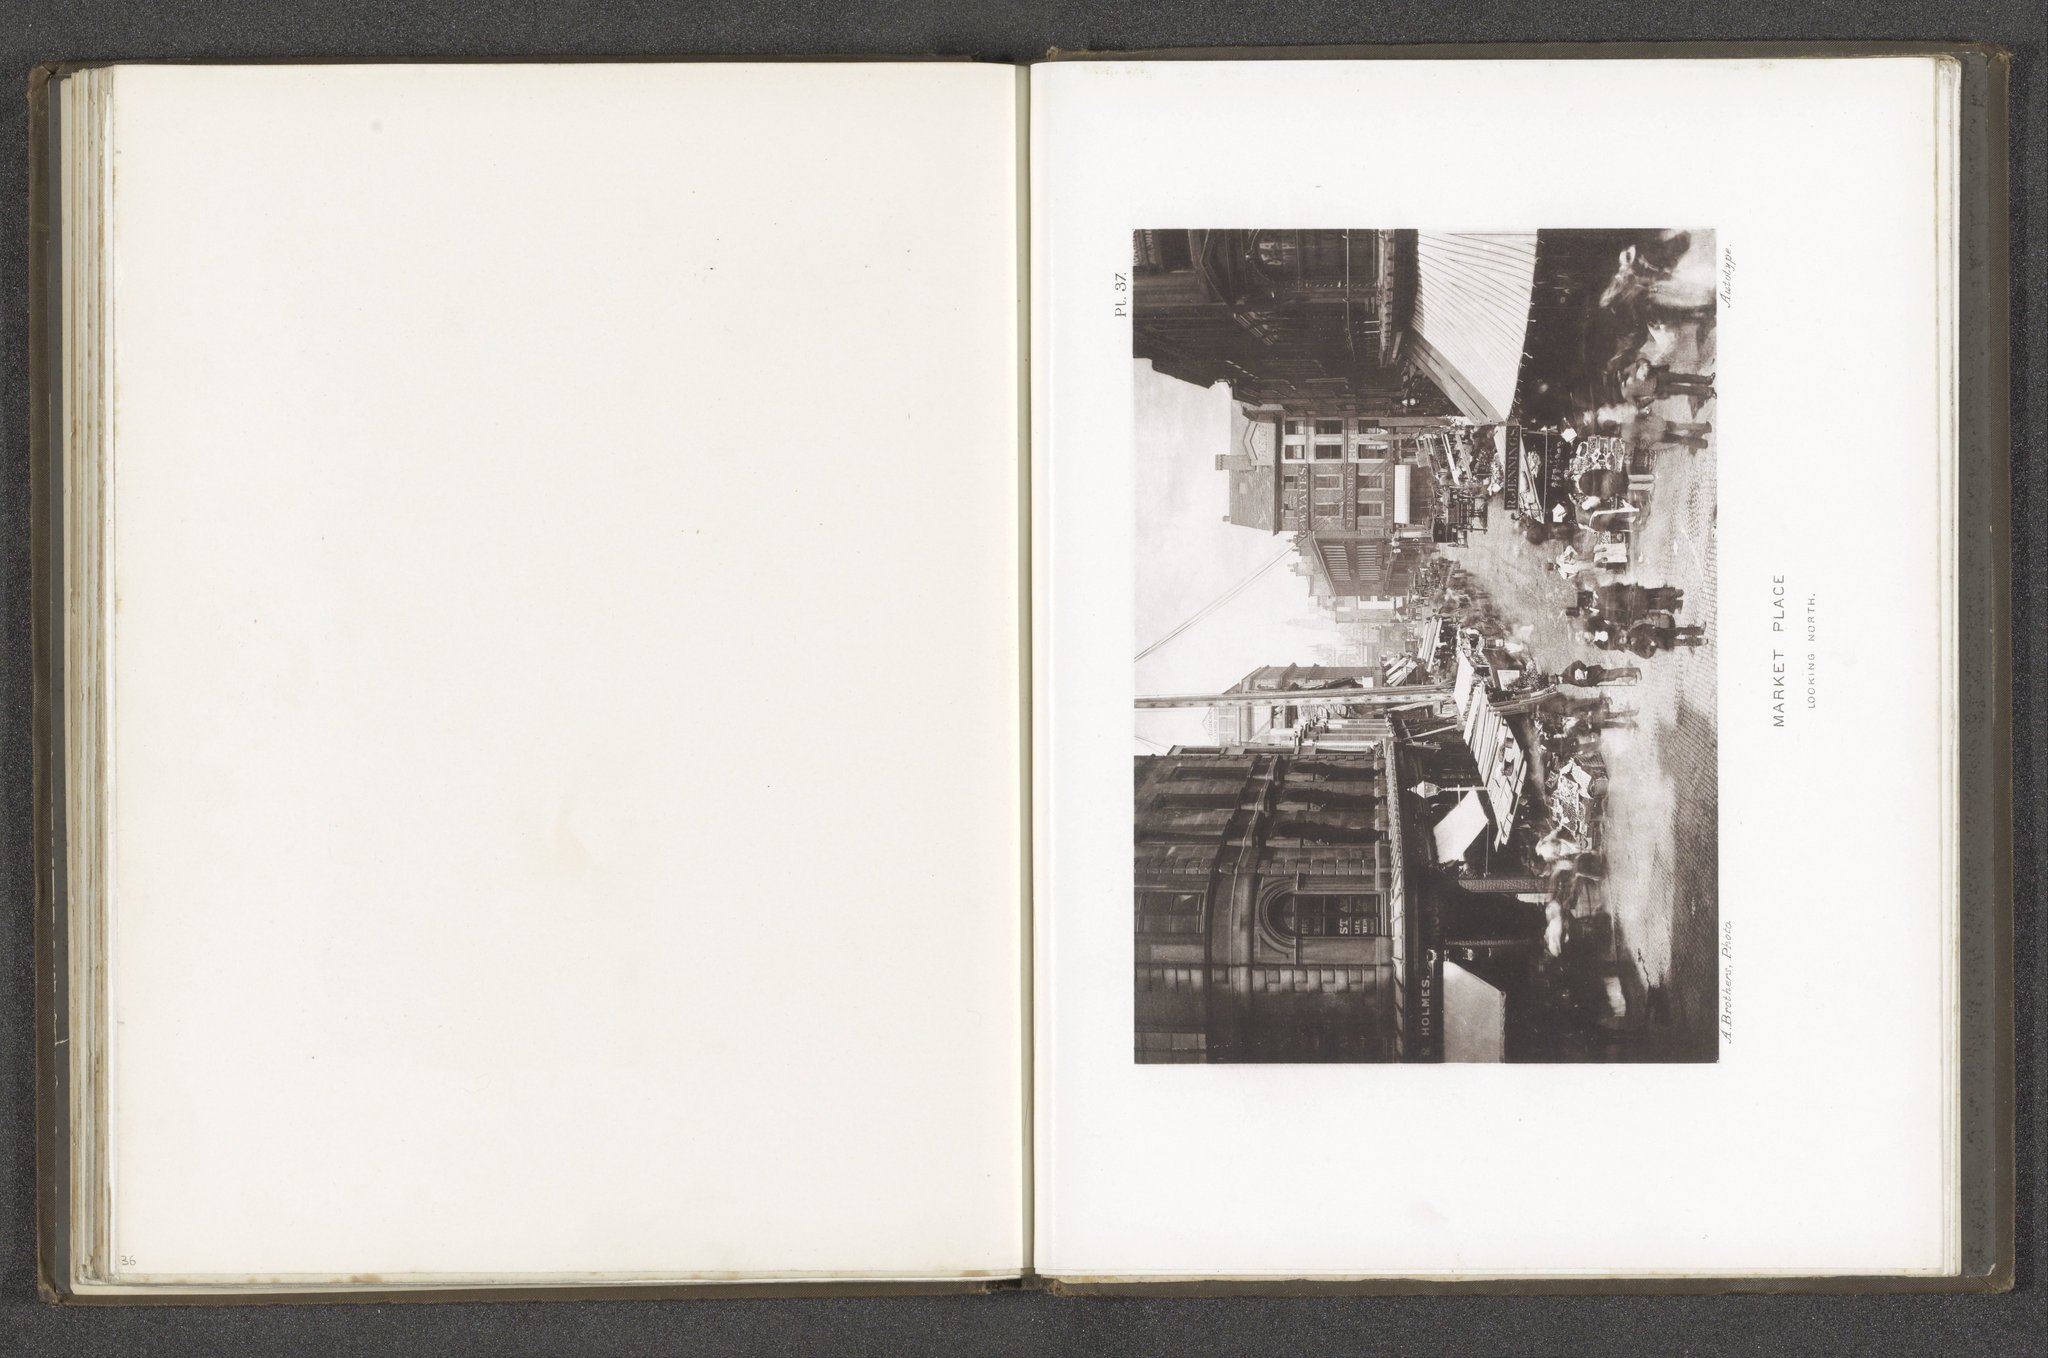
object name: page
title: Market Place, looking north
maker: Anonymous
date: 1868-1878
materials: paper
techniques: photograph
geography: manchester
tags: four-wheeled, animal-drawn vehicle, e.g.: cab, carriage, coach, market, manchester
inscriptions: number: ‘Pl. 37.’